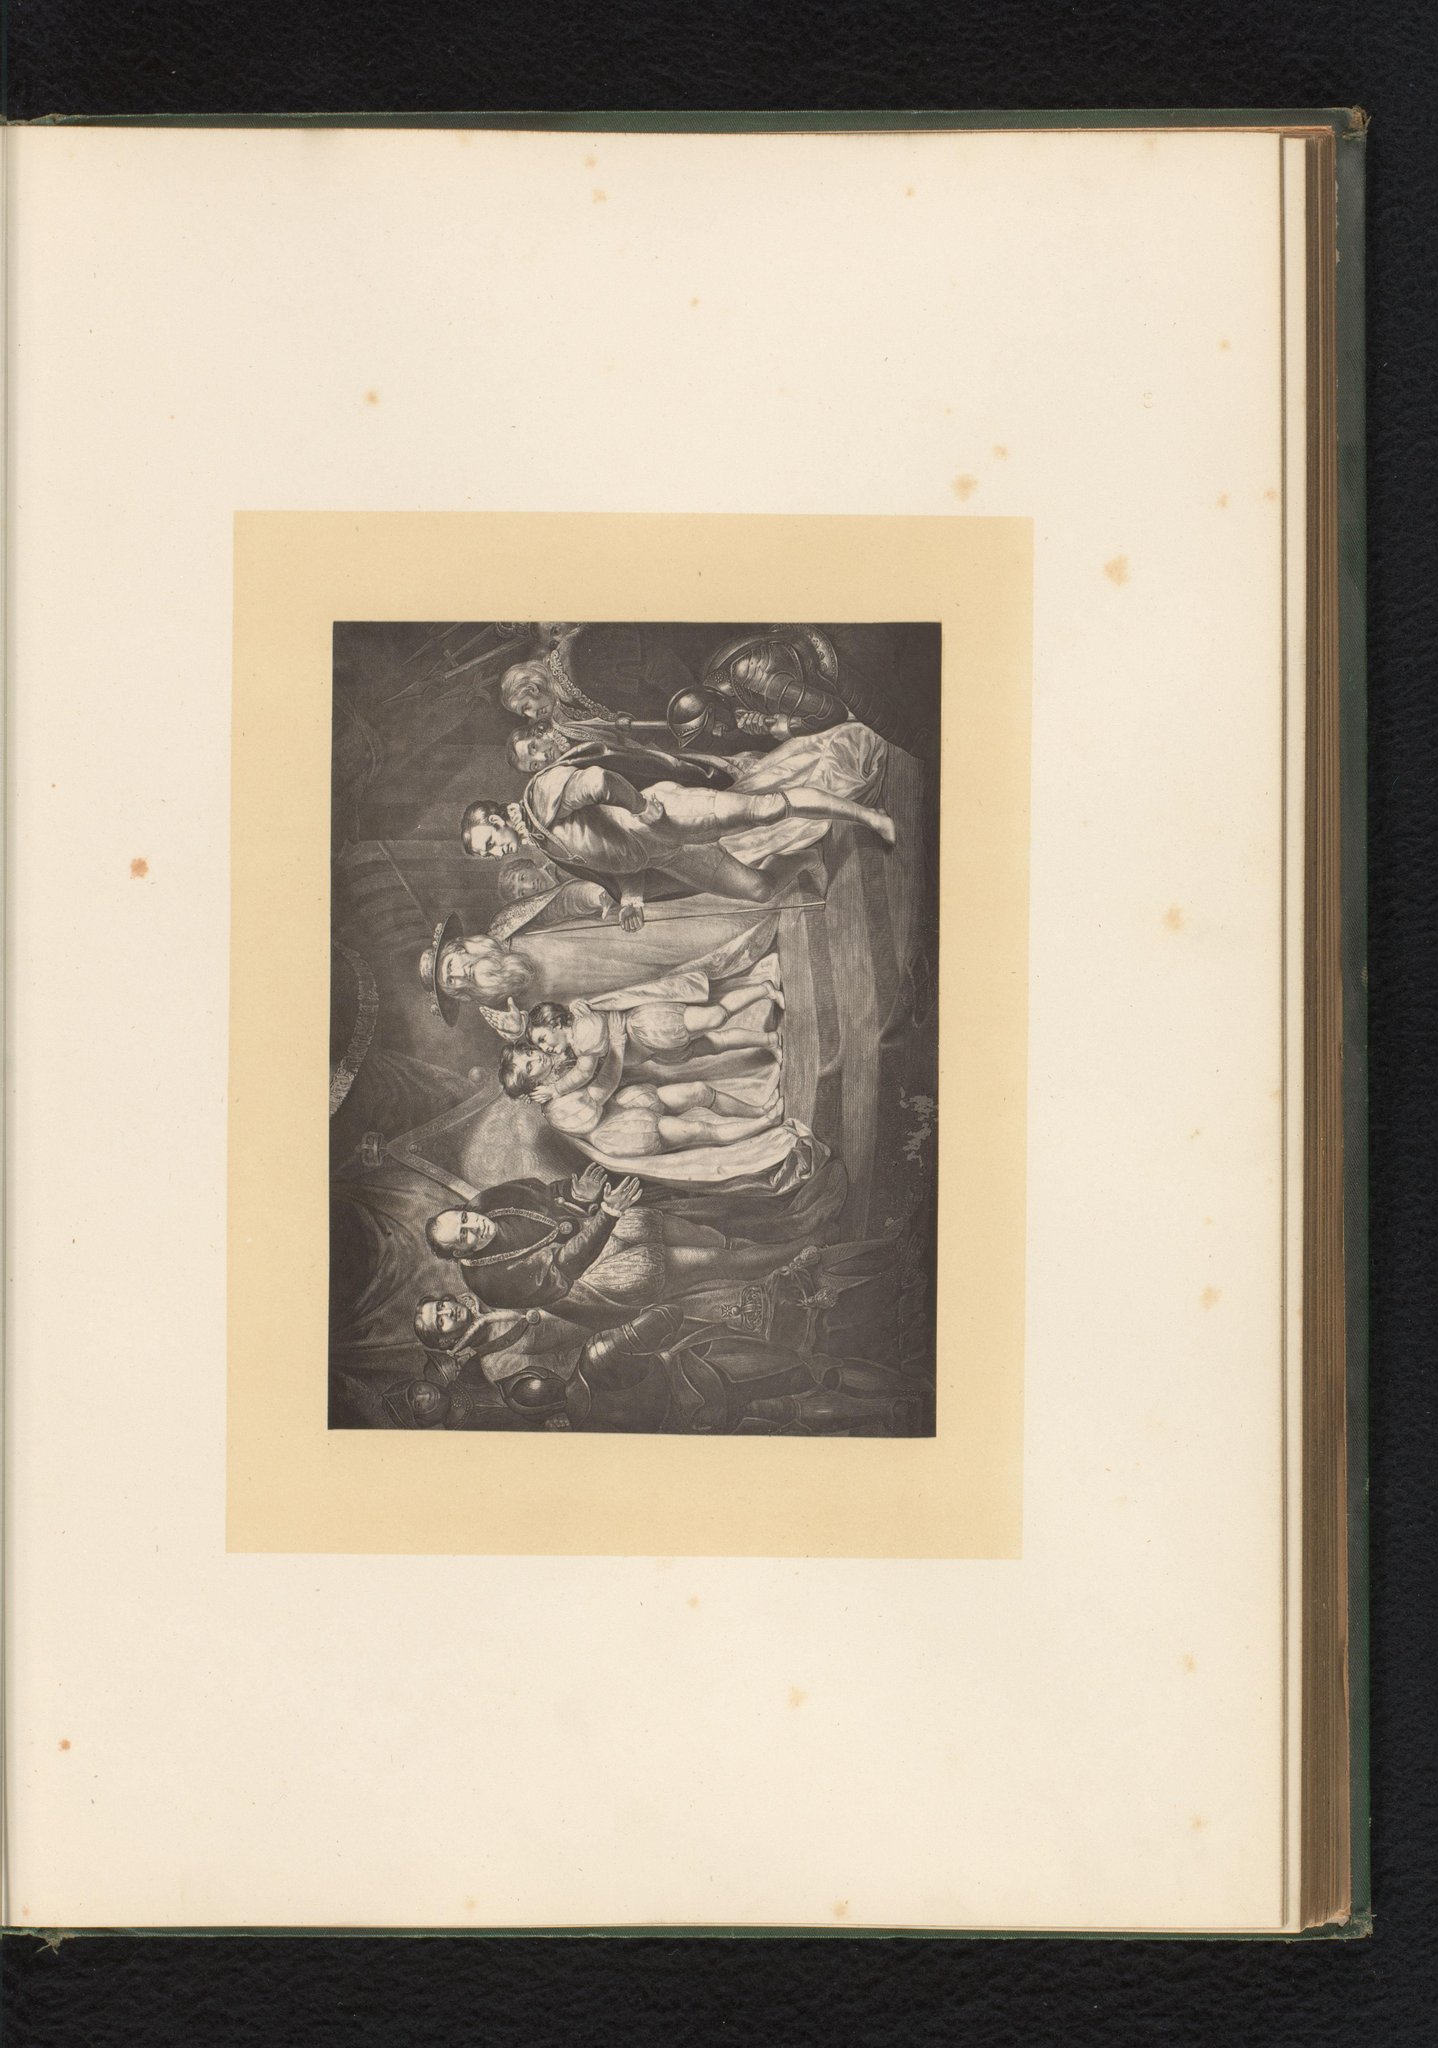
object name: reproduction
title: King Richard the Third, Act III, Scene 1: London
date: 1874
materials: paper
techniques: woodburytype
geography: london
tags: theatre, theatrical performance